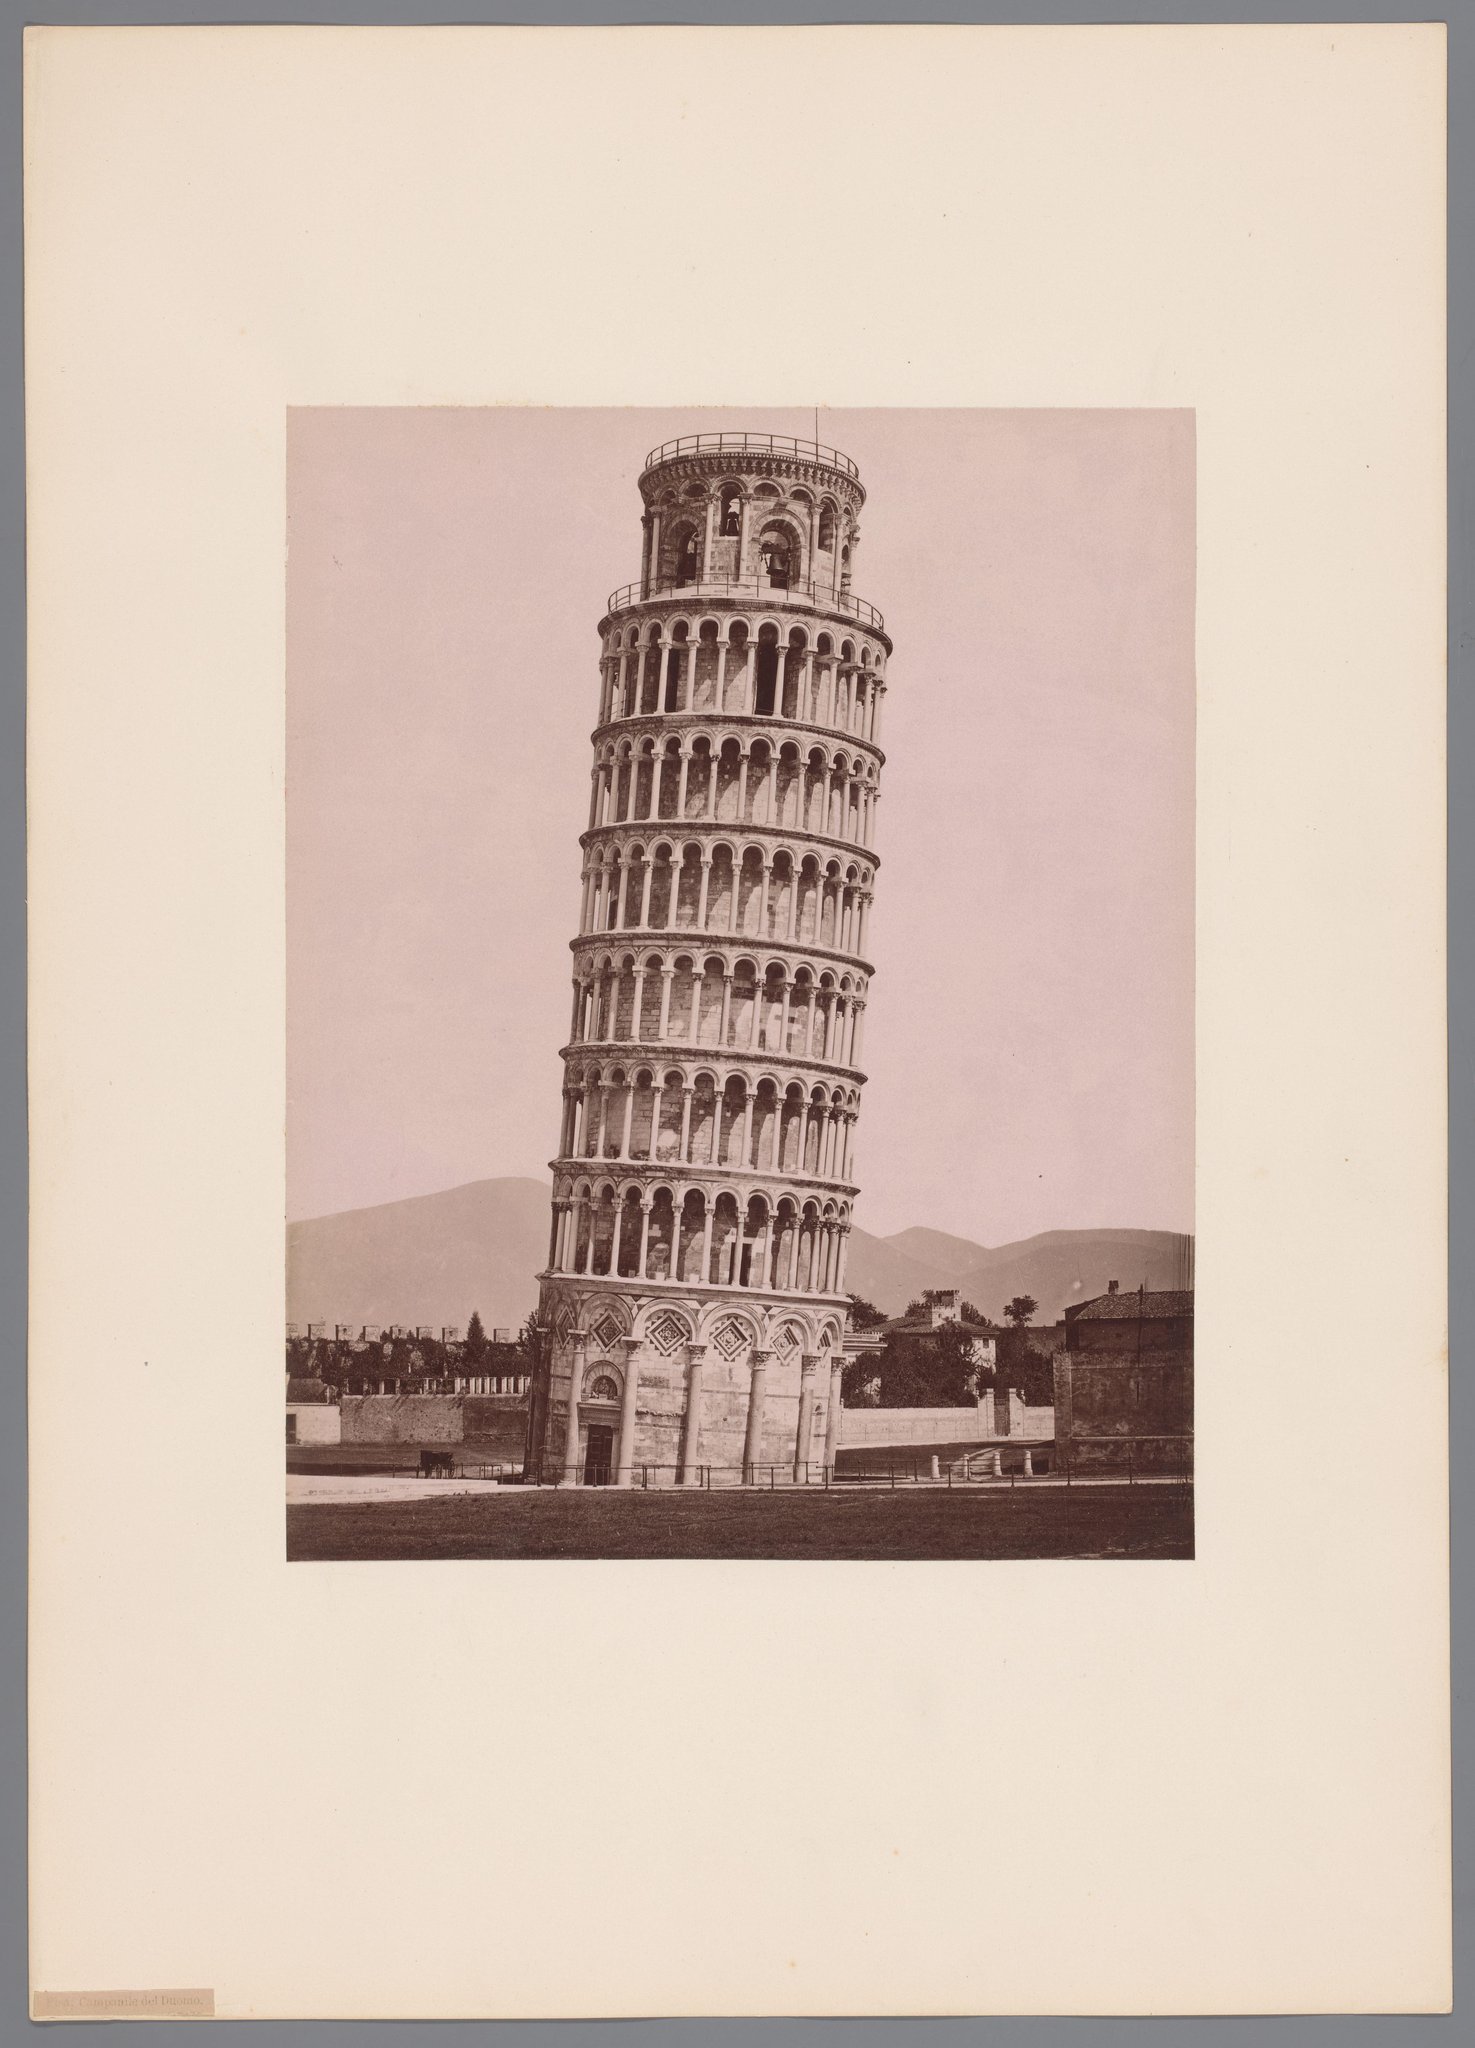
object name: photograph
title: Campanile del Duomo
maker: alfredo noack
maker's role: fotograaf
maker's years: 1833-1895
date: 1858-1893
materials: cardboard, paper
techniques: albumen print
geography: pisa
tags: tower (of house or building)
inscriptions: inscription: ‘Noack (t)’